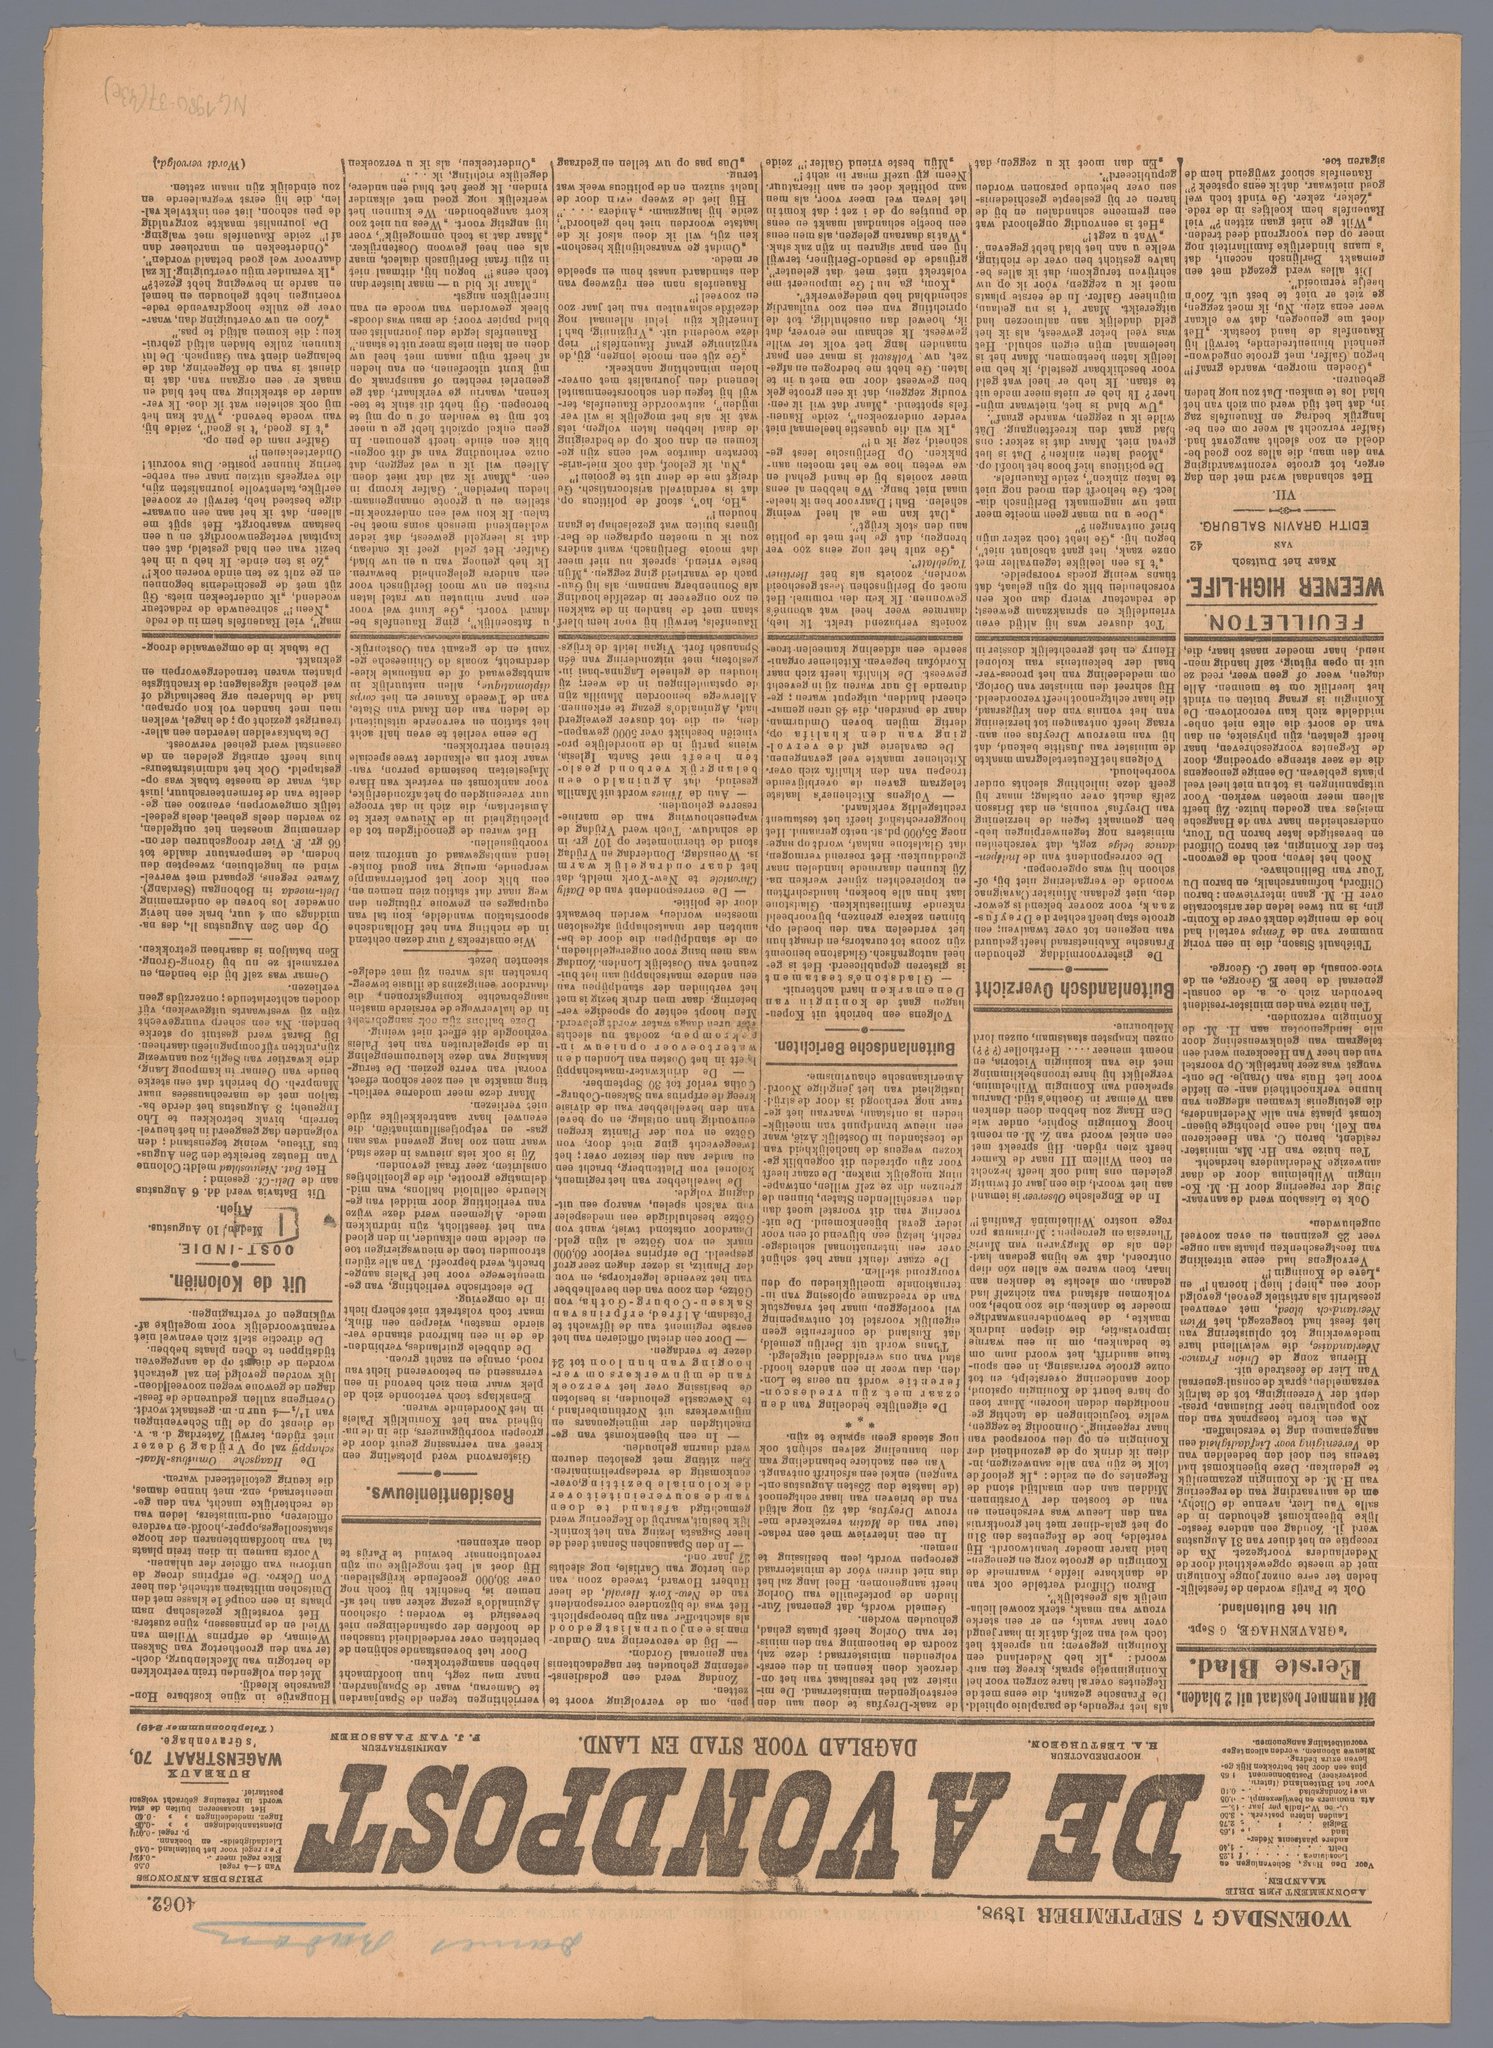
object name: newspaper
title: de Avondpost; dagblad voor stad en land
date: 1898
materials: paper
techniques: printing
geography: the hague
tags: wilhelmina of the netherlands, netherlands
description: Eén van een serie kranten, nrs. 4056 t/m 4073, van "de Avondpost" met berichten over de inhuldiging van koningin Wilhelmina 1898.